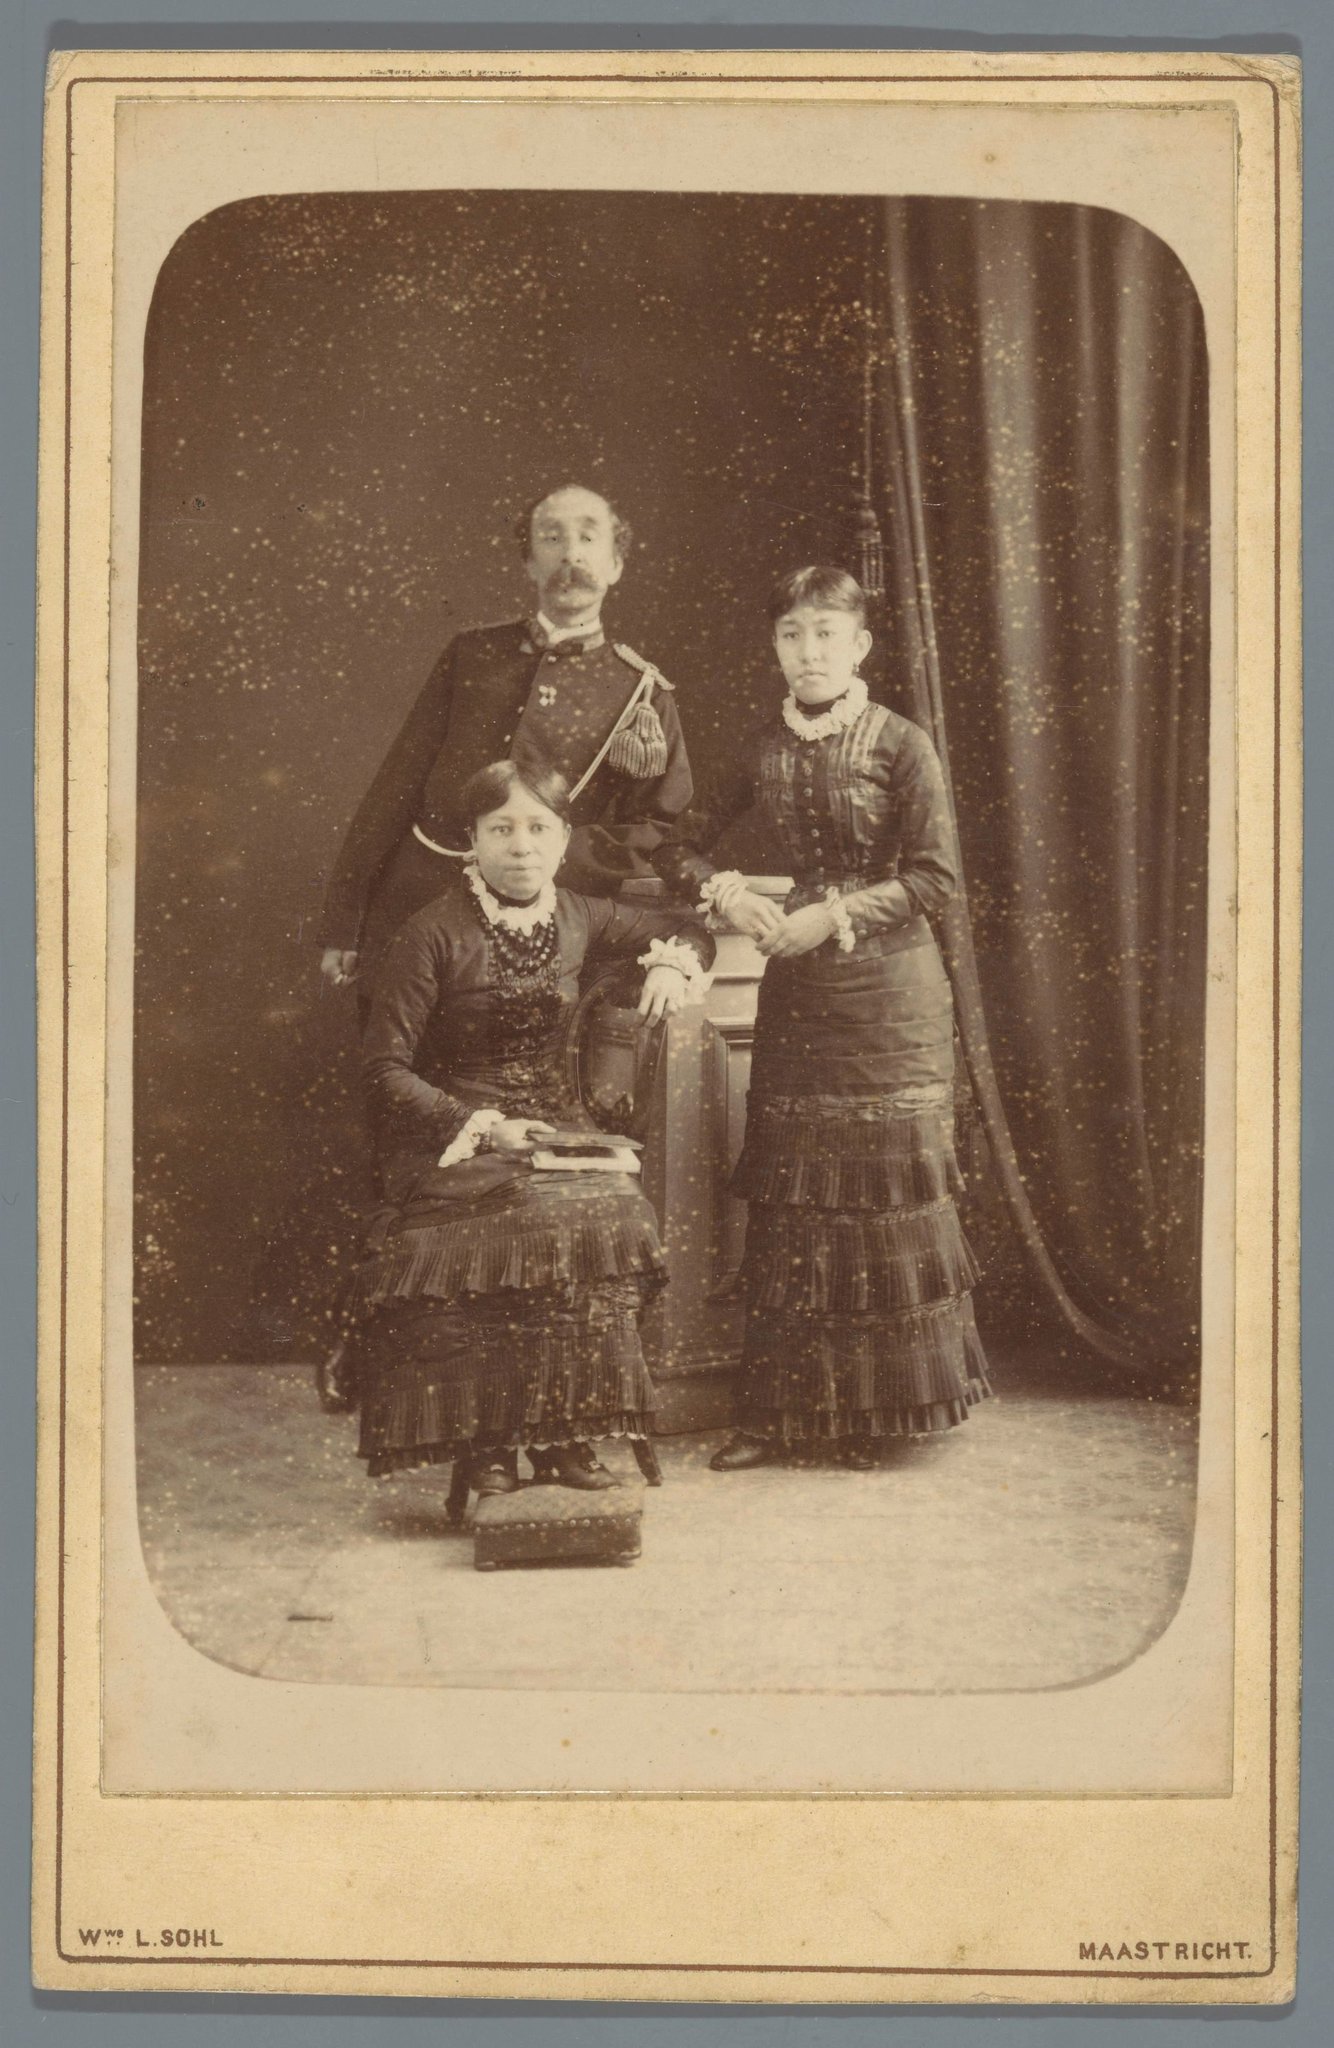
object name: cabinet photograph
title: Portret van een onbekend gezin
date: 1875-1890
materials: cardboard, photographic support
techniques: albumen print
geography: maastricht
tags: family group, especially parents with their child(ren)